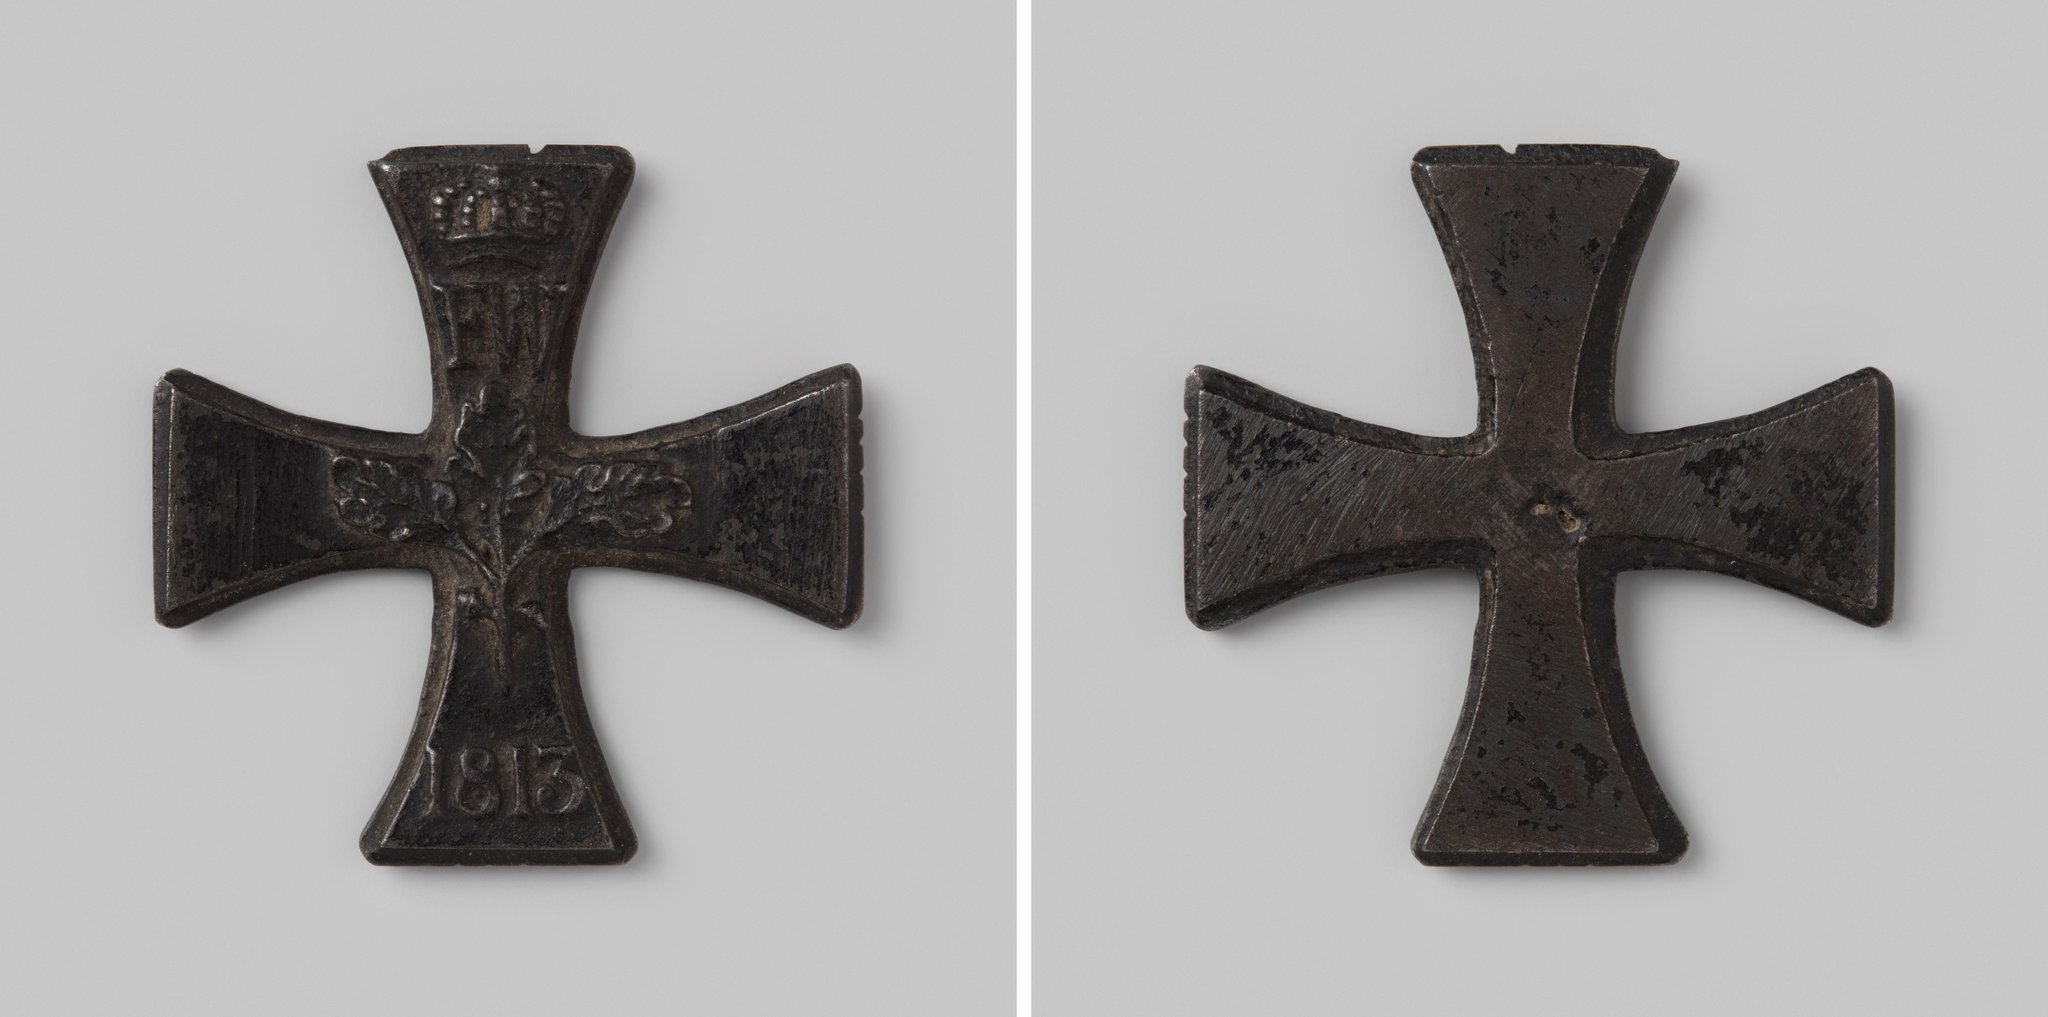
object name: history medal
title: IJzeren Kruis 1813 (Pruisen) zonder rand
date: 1813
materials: iron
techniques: casting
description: Gegoten ijzeren kruis zonder rand, op de voorzijde een gekroond monogram FW, een driebladige eikentak en het jaartal 1813, de keerzijde blanco.